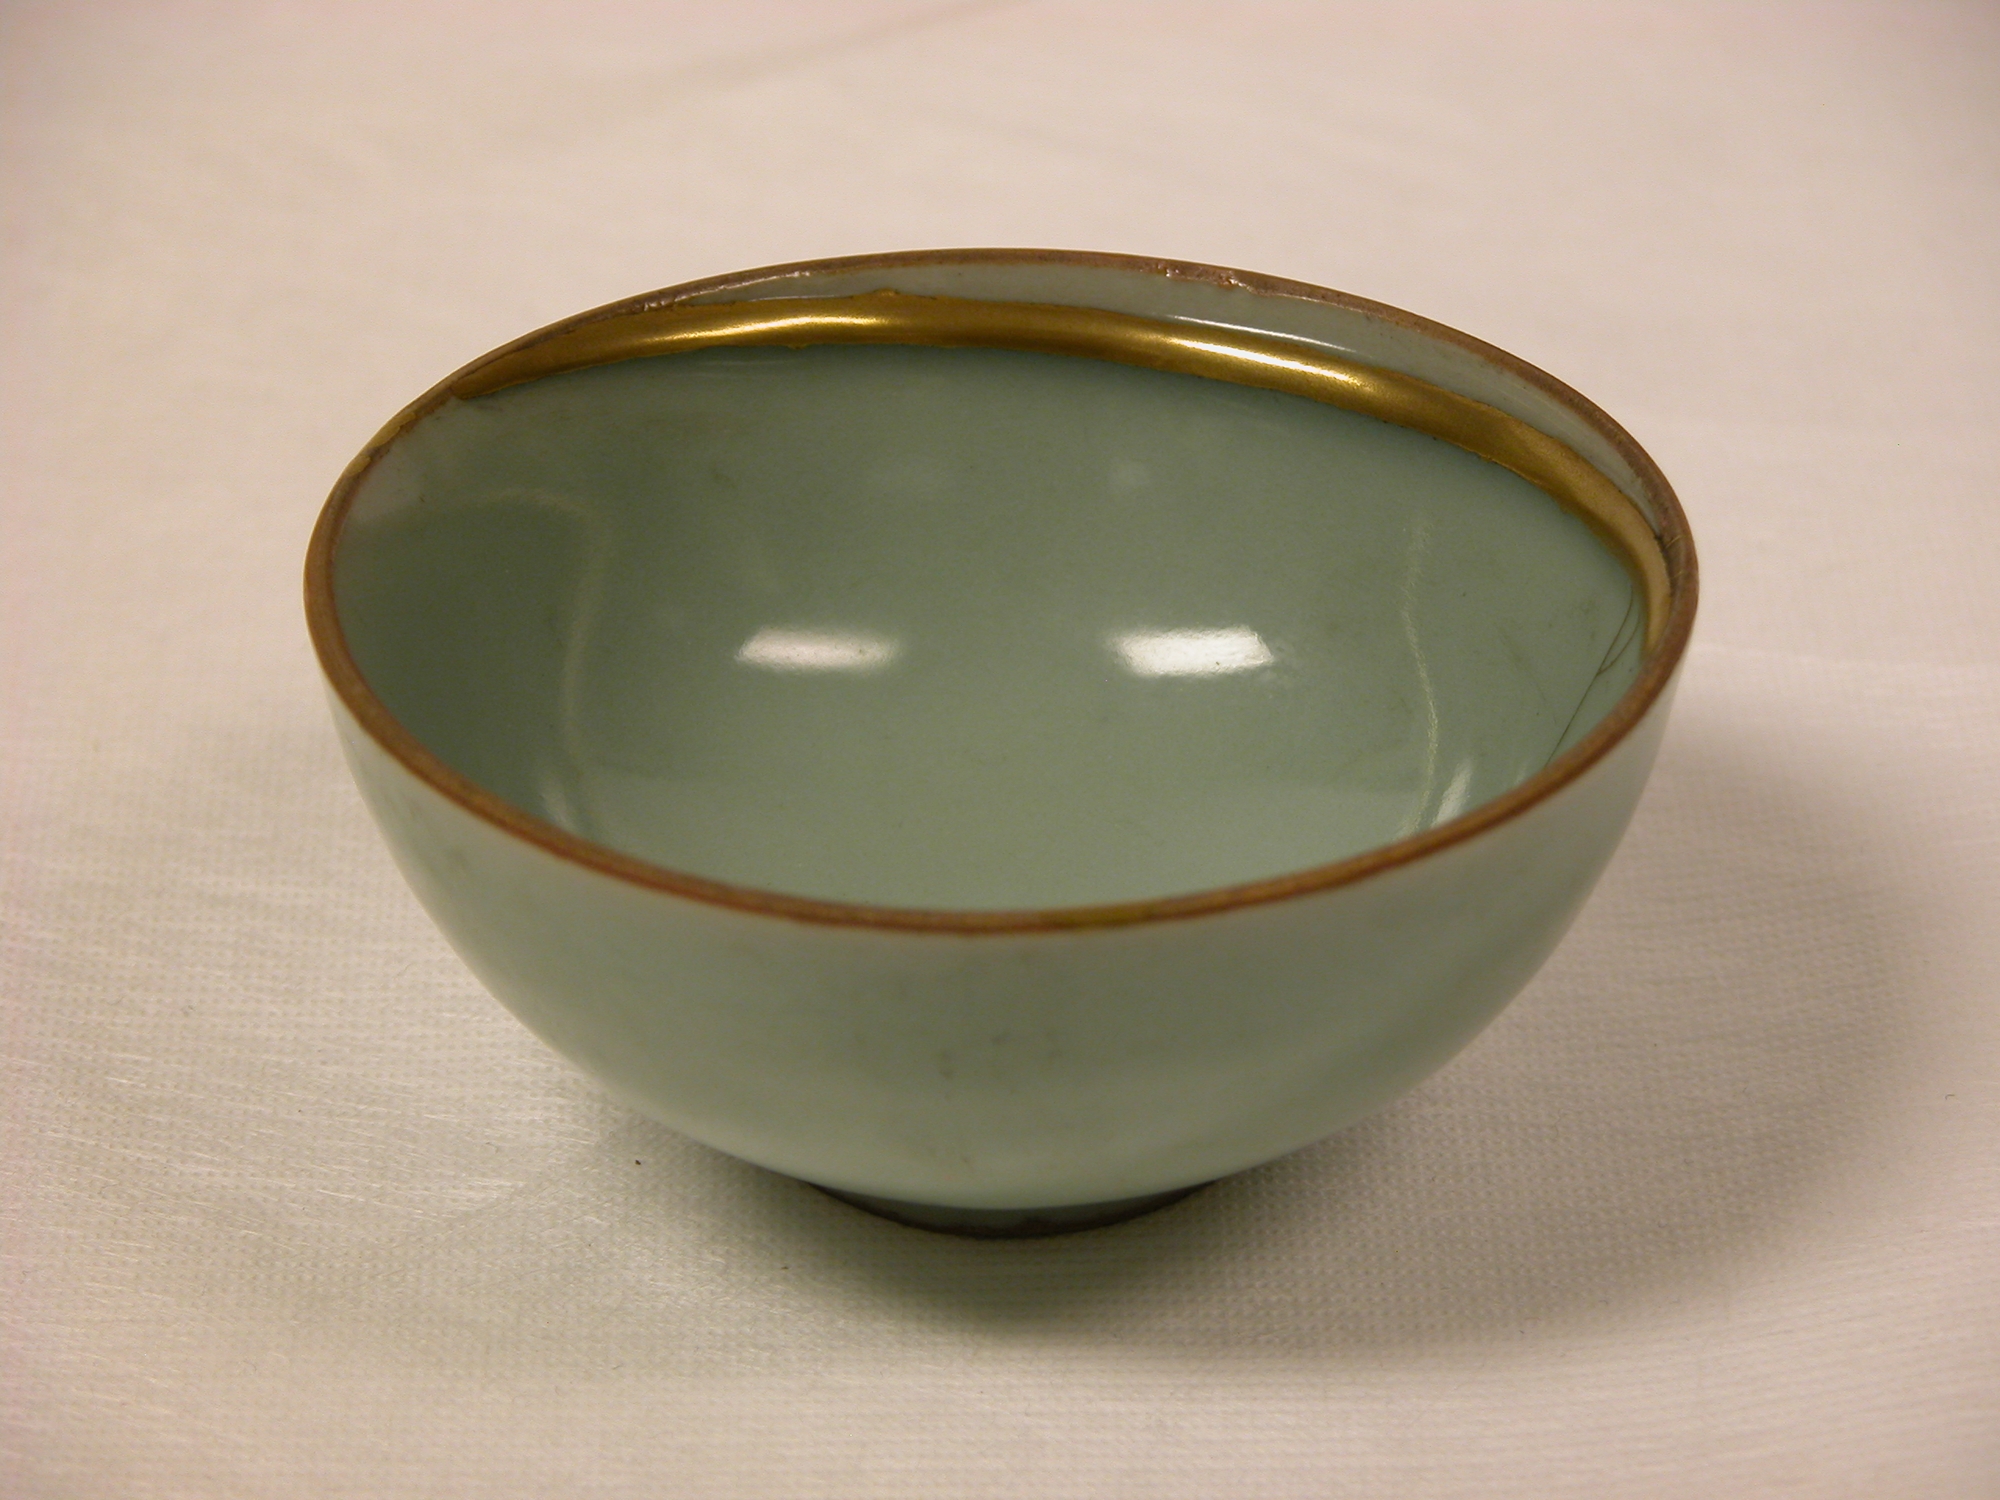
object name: cup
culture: chinese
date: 960-1279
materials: pottery